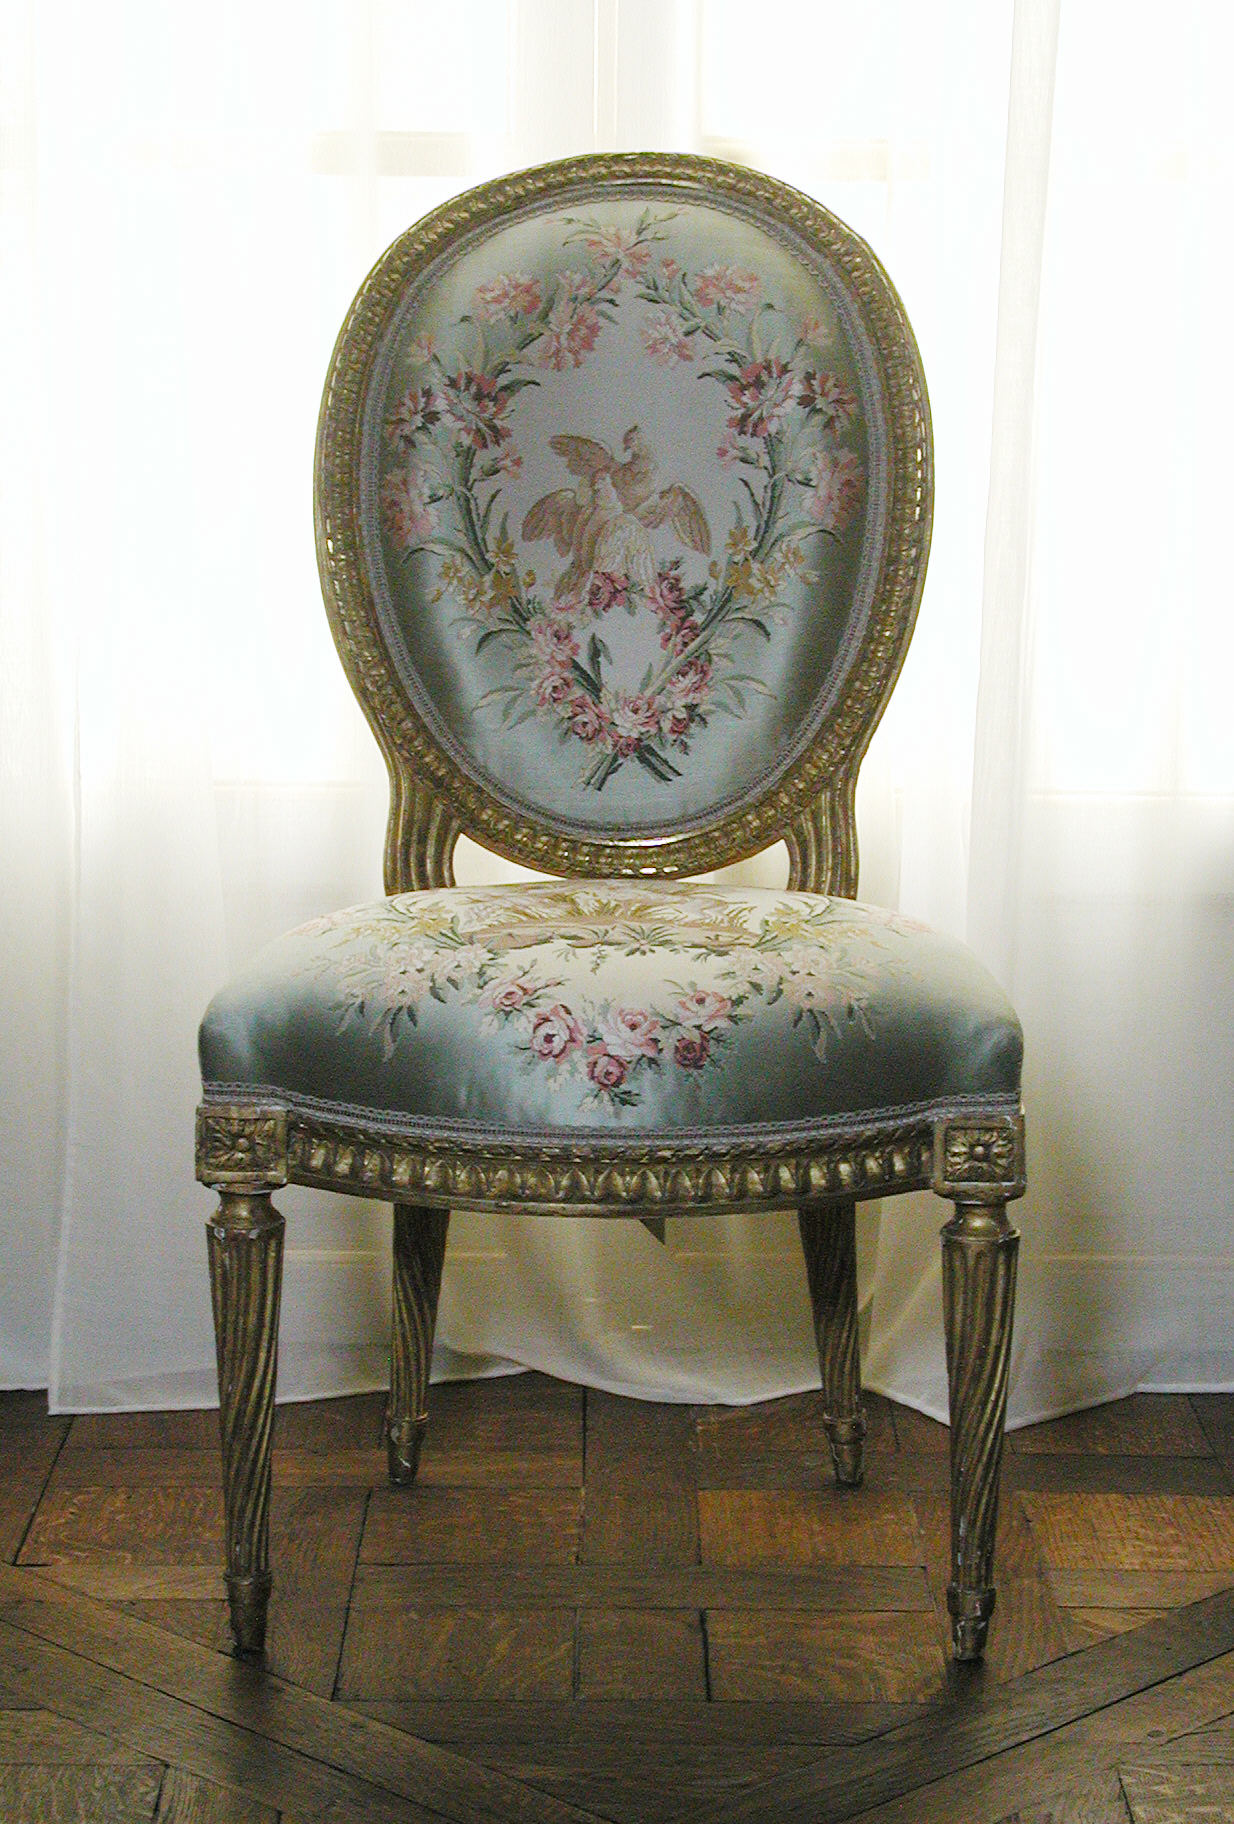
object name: side chair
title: Side chair (one of a pair)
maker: jean-jacques pothier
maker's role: maker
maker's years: 1750-1780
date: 1775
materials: wood, silk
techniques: carving, gilding, moire